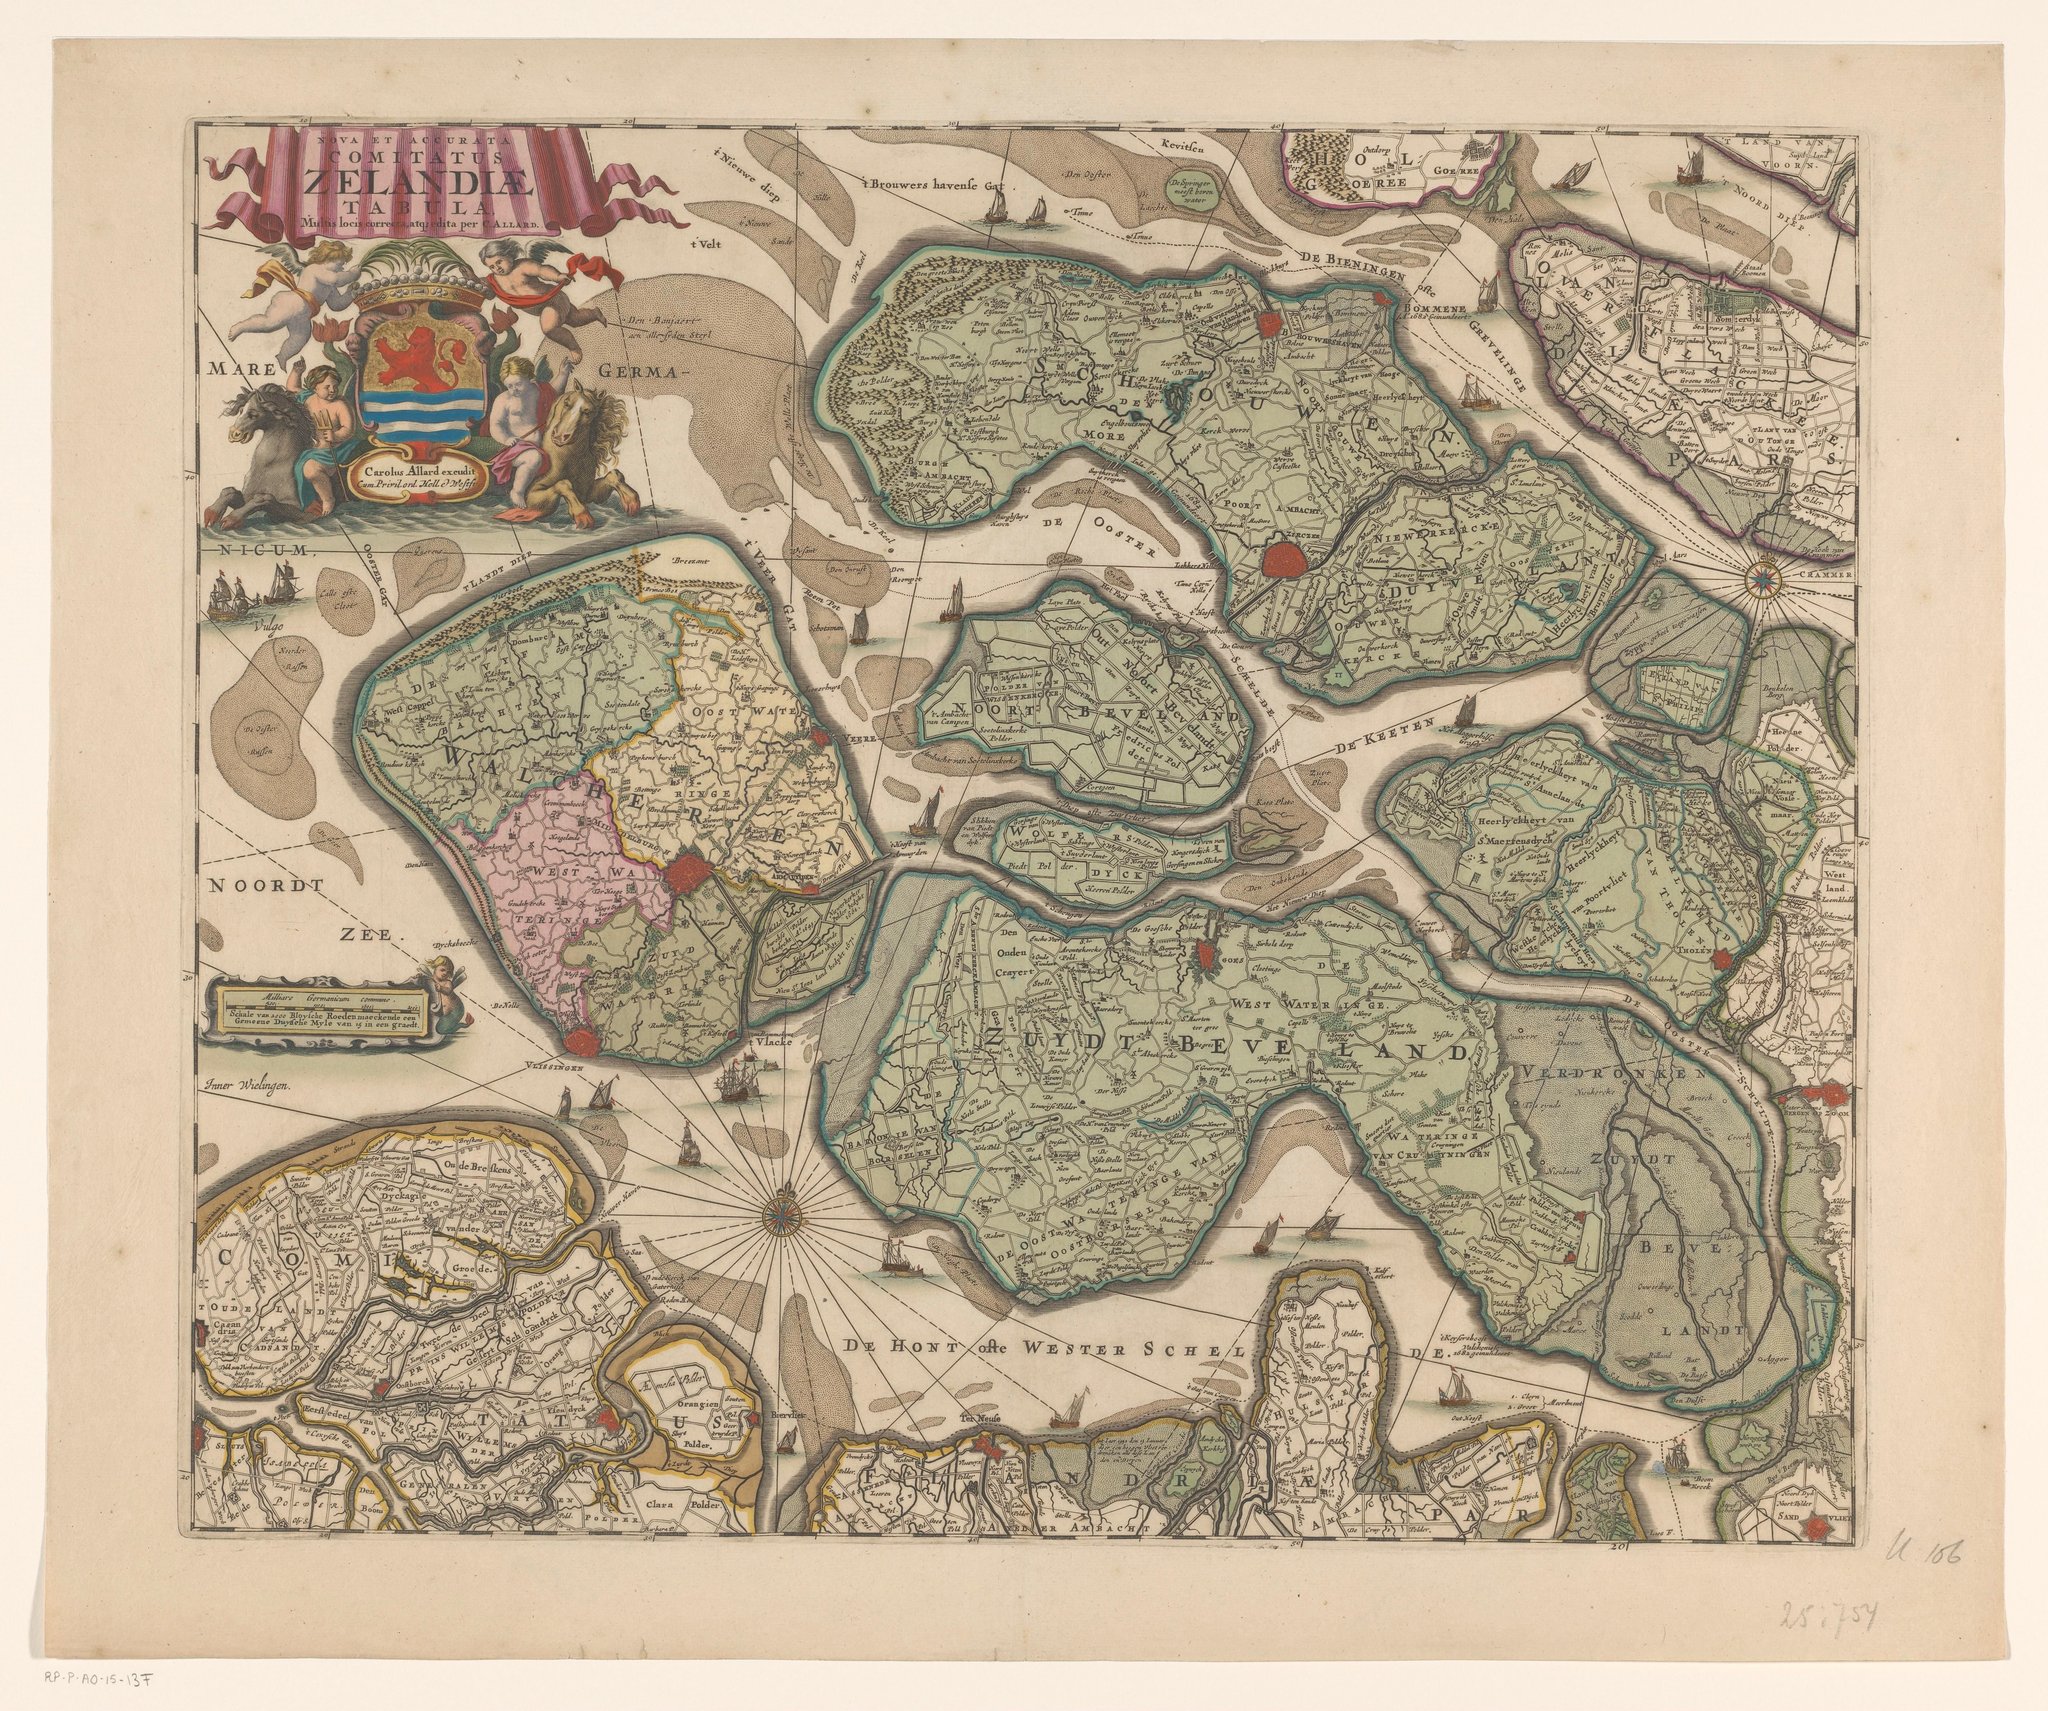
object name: print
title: Kaart van Zeeland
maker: Anonymous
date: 1674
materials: paper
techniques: engraving, etching, hand coloring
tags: maps of separate countries or regions, coat of arms (as symbol of the state, etc.) (+ province; provincial), zeeland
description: Deze staat van prent ook gebruikt in een aantal door Carel Allard uitgegeven atlassen. Deze atlassen hebben geen vaste samenstelling. Prent vervolgens ook nog gebruikt in: Atlas minor sive geographia comepndiosa, qua orbis terrarum per paucas attamen novissimas ostenditur. Amsterdam: Adiaan Braakman, 1706. En in: Aa, Pieter van der. La galerie agreable du monde (...). 66 delen. Leiden: Pieter van der Aa, 1728, dl. 20. En in: Atlas. Amsterdam: Reinier en Josua Ottens, s.a. [1726-1750]. Zie ook RP-P-AO-15-13G.